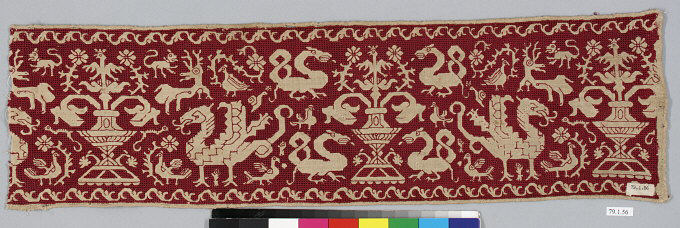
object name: border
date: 1601-1700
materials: linen, silk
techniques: embroidery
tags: birds,mythical creatures